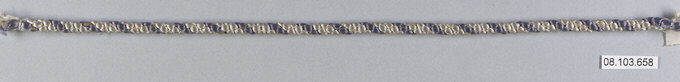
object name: cord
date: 1701-1900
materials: silk